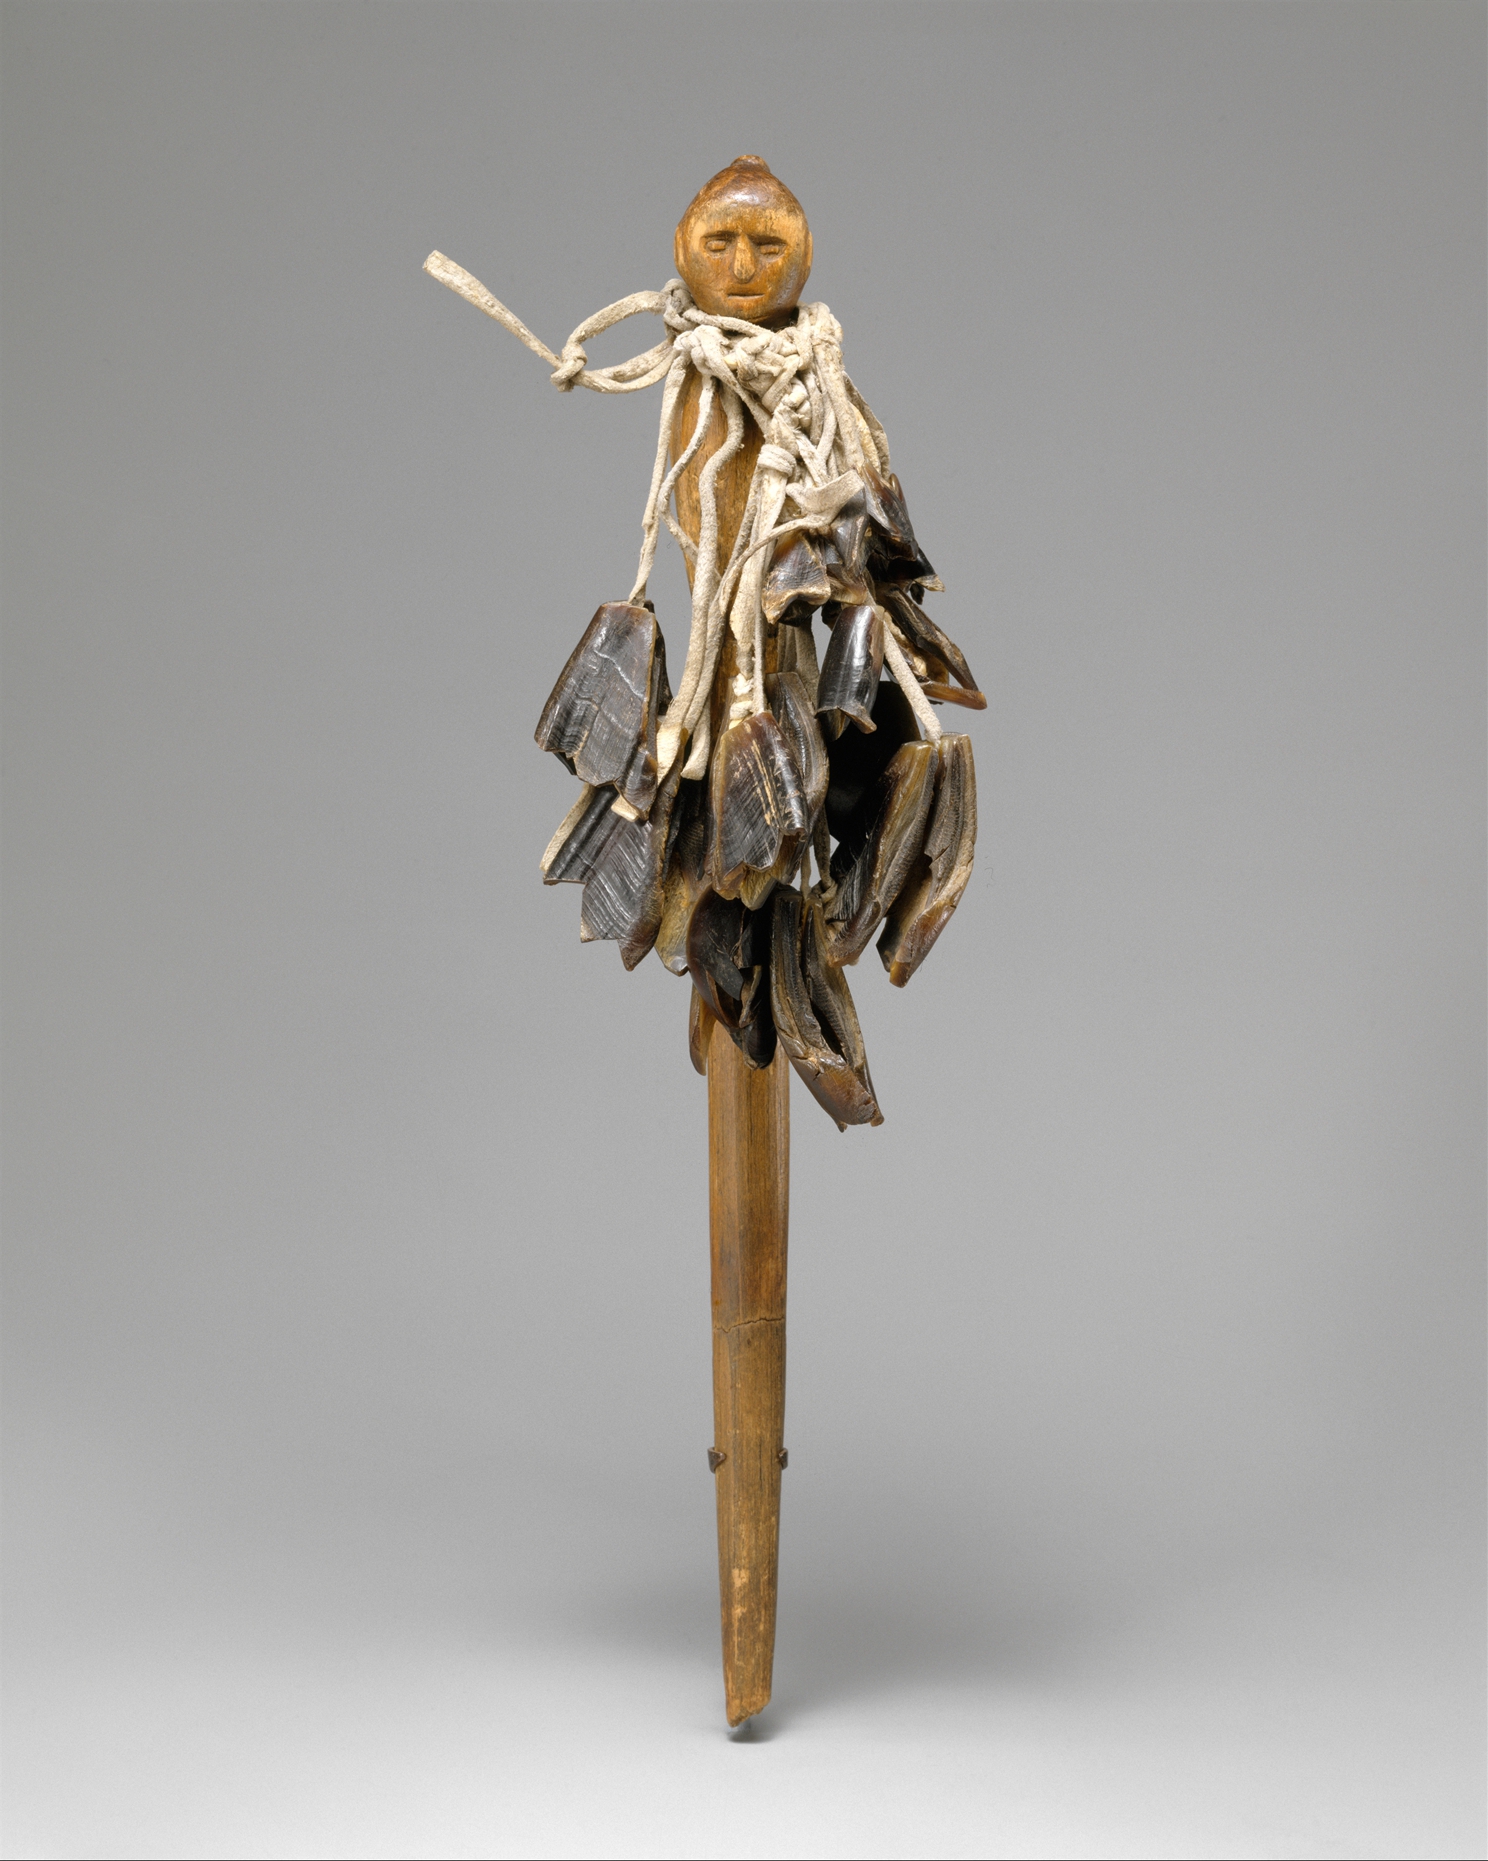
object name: staff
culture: potawatomi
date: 1834-1866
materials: skin, wood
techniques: tanning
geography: united states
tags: heads